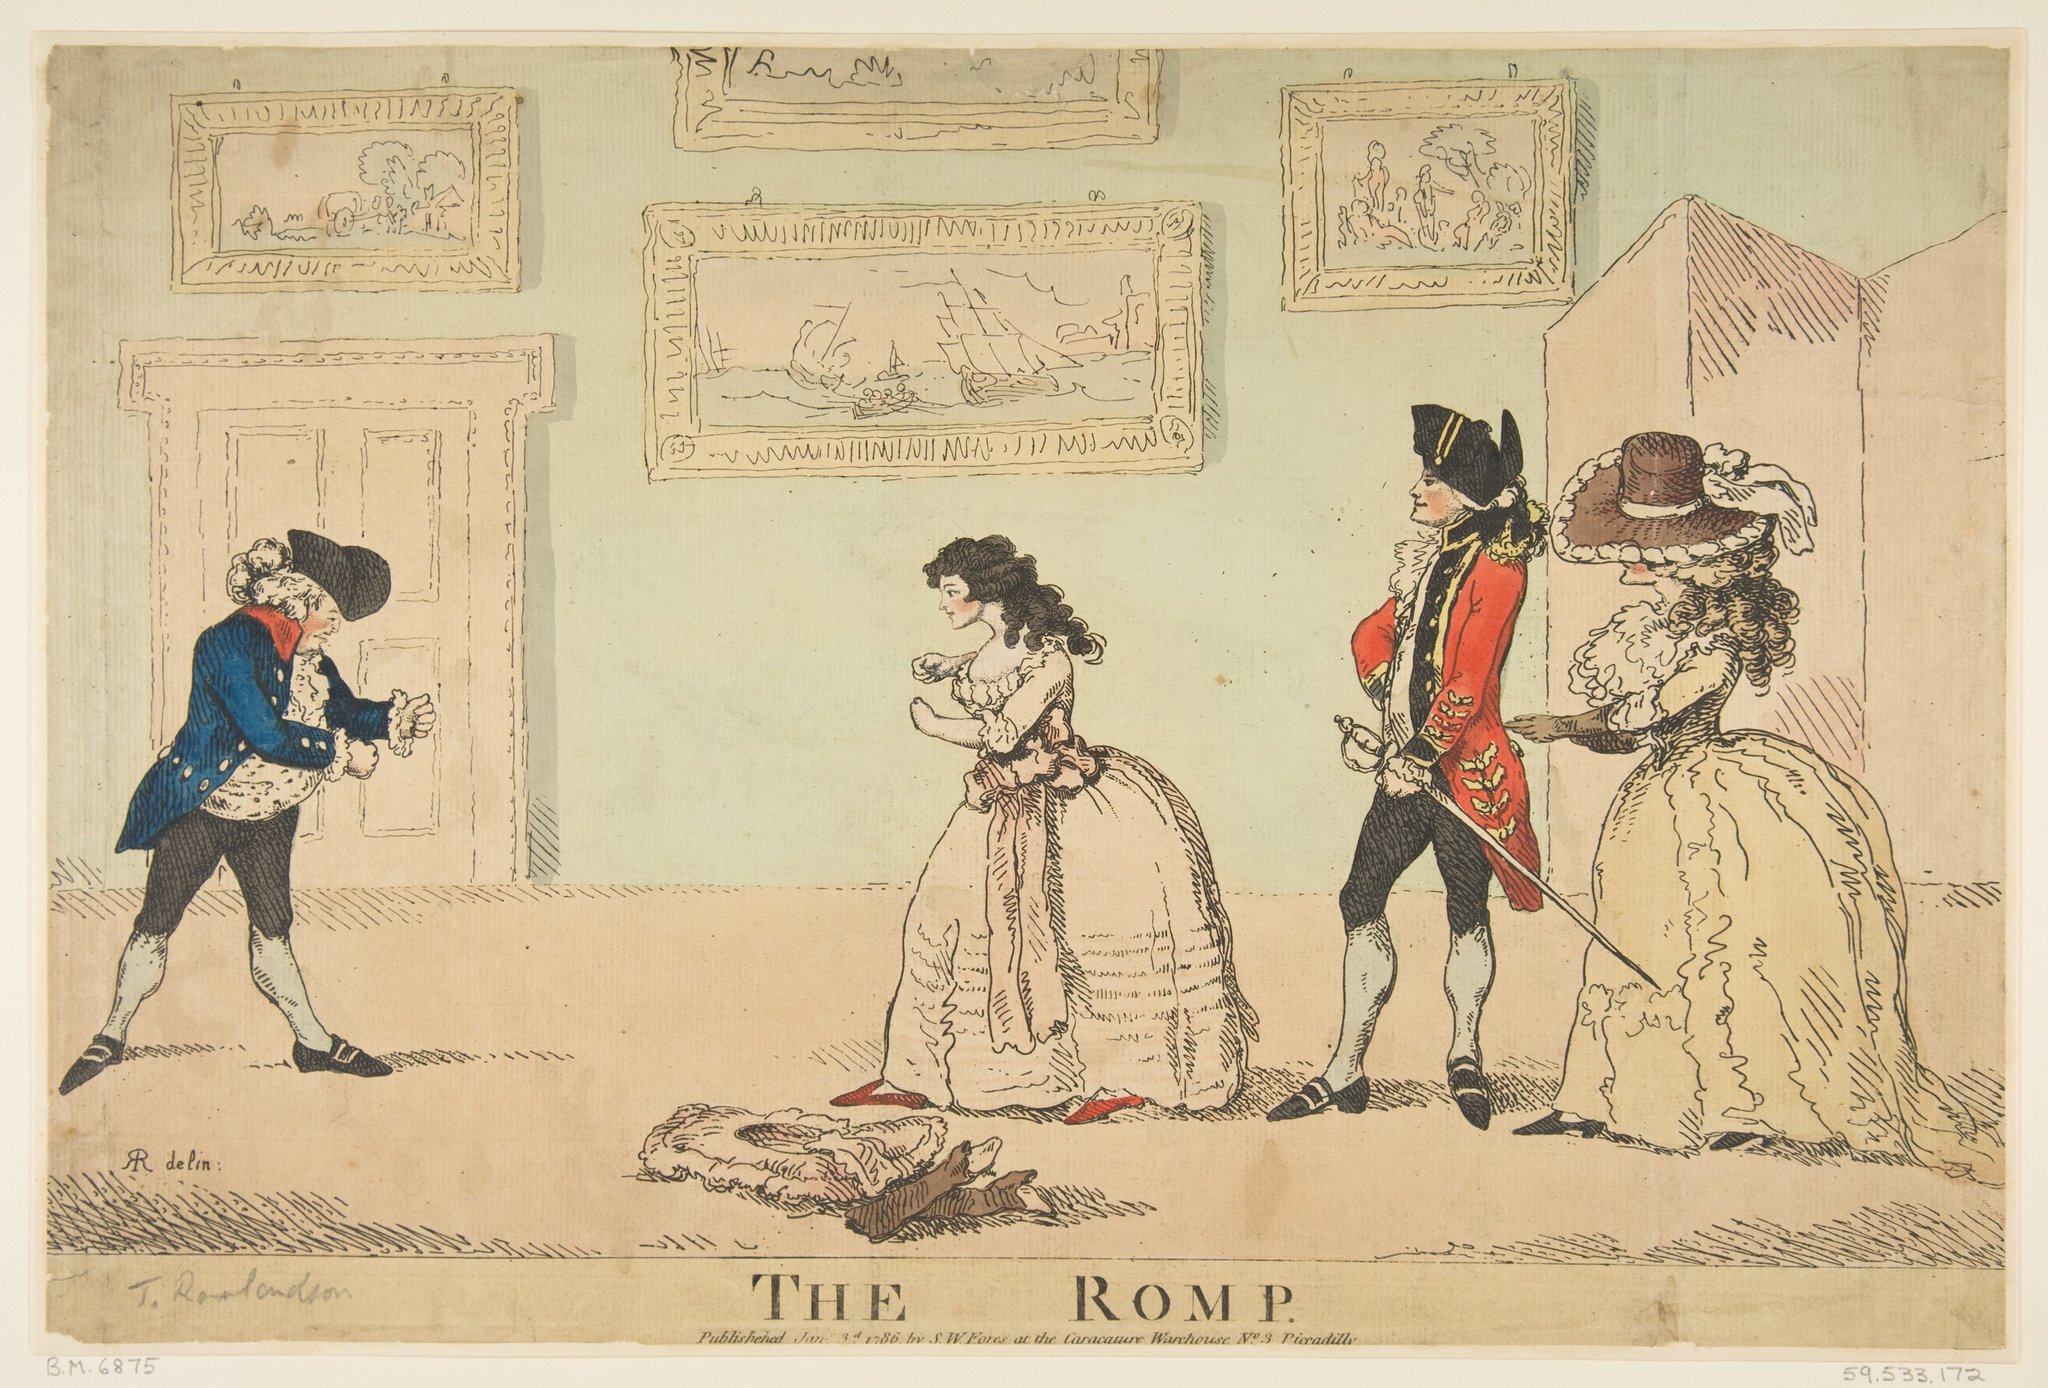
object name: print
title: The Romp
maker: r. rushworth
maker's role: artist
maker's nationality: british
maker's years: 1750-1800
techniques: etching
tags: theatre,men,women,actors